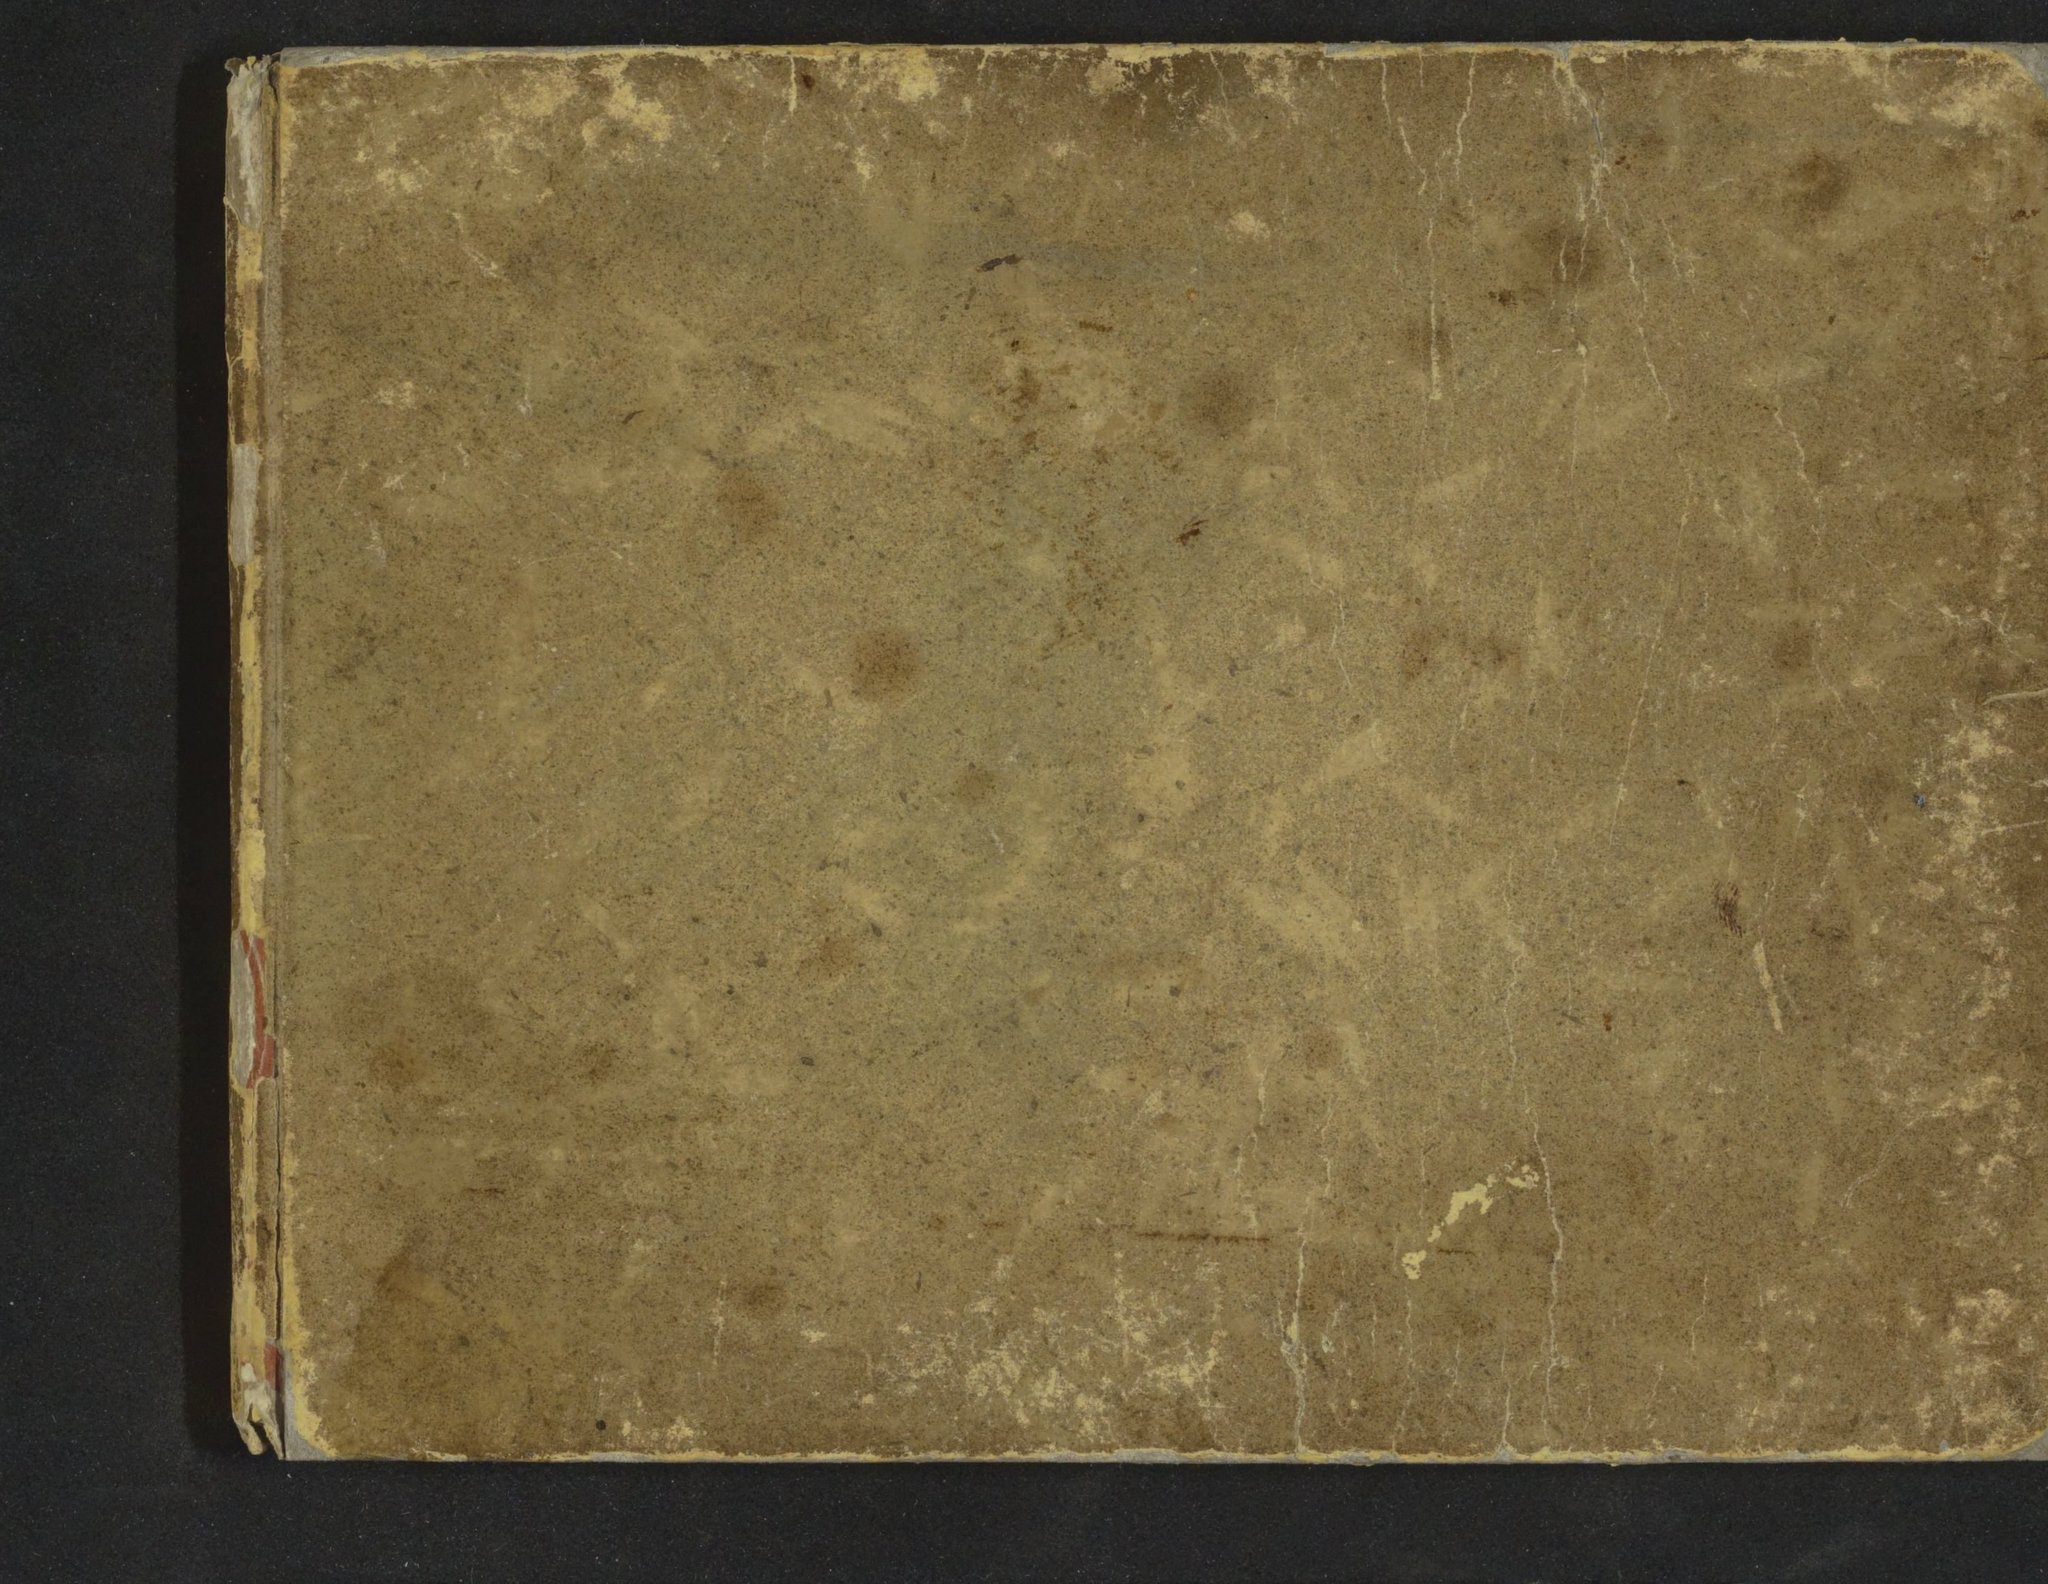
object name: sketchbook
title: Schetsboek met 36 bladen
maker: willem hendrik schmidt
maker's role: draughtsman, painter, print maker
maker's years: 1809-1849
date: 1819-1849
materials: cardboard, chalk, ink, paper, pencil, watercolor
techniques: brush, pen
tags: anatomy (non-medical), cottage - aa - civic architecture: inside, architecture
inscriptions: collector's mark: Lugt 2228a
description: De volgende bladen uit het schetsboek zijn blanco: 2(V), 4(V), 6(V) t/m 9(V), 11(V) t/m 14(V), 15, 17, 18(R), 19, 20, 21(R) t/m 26(R), 28(R), 29(R), 31(R) t/m 34(R).